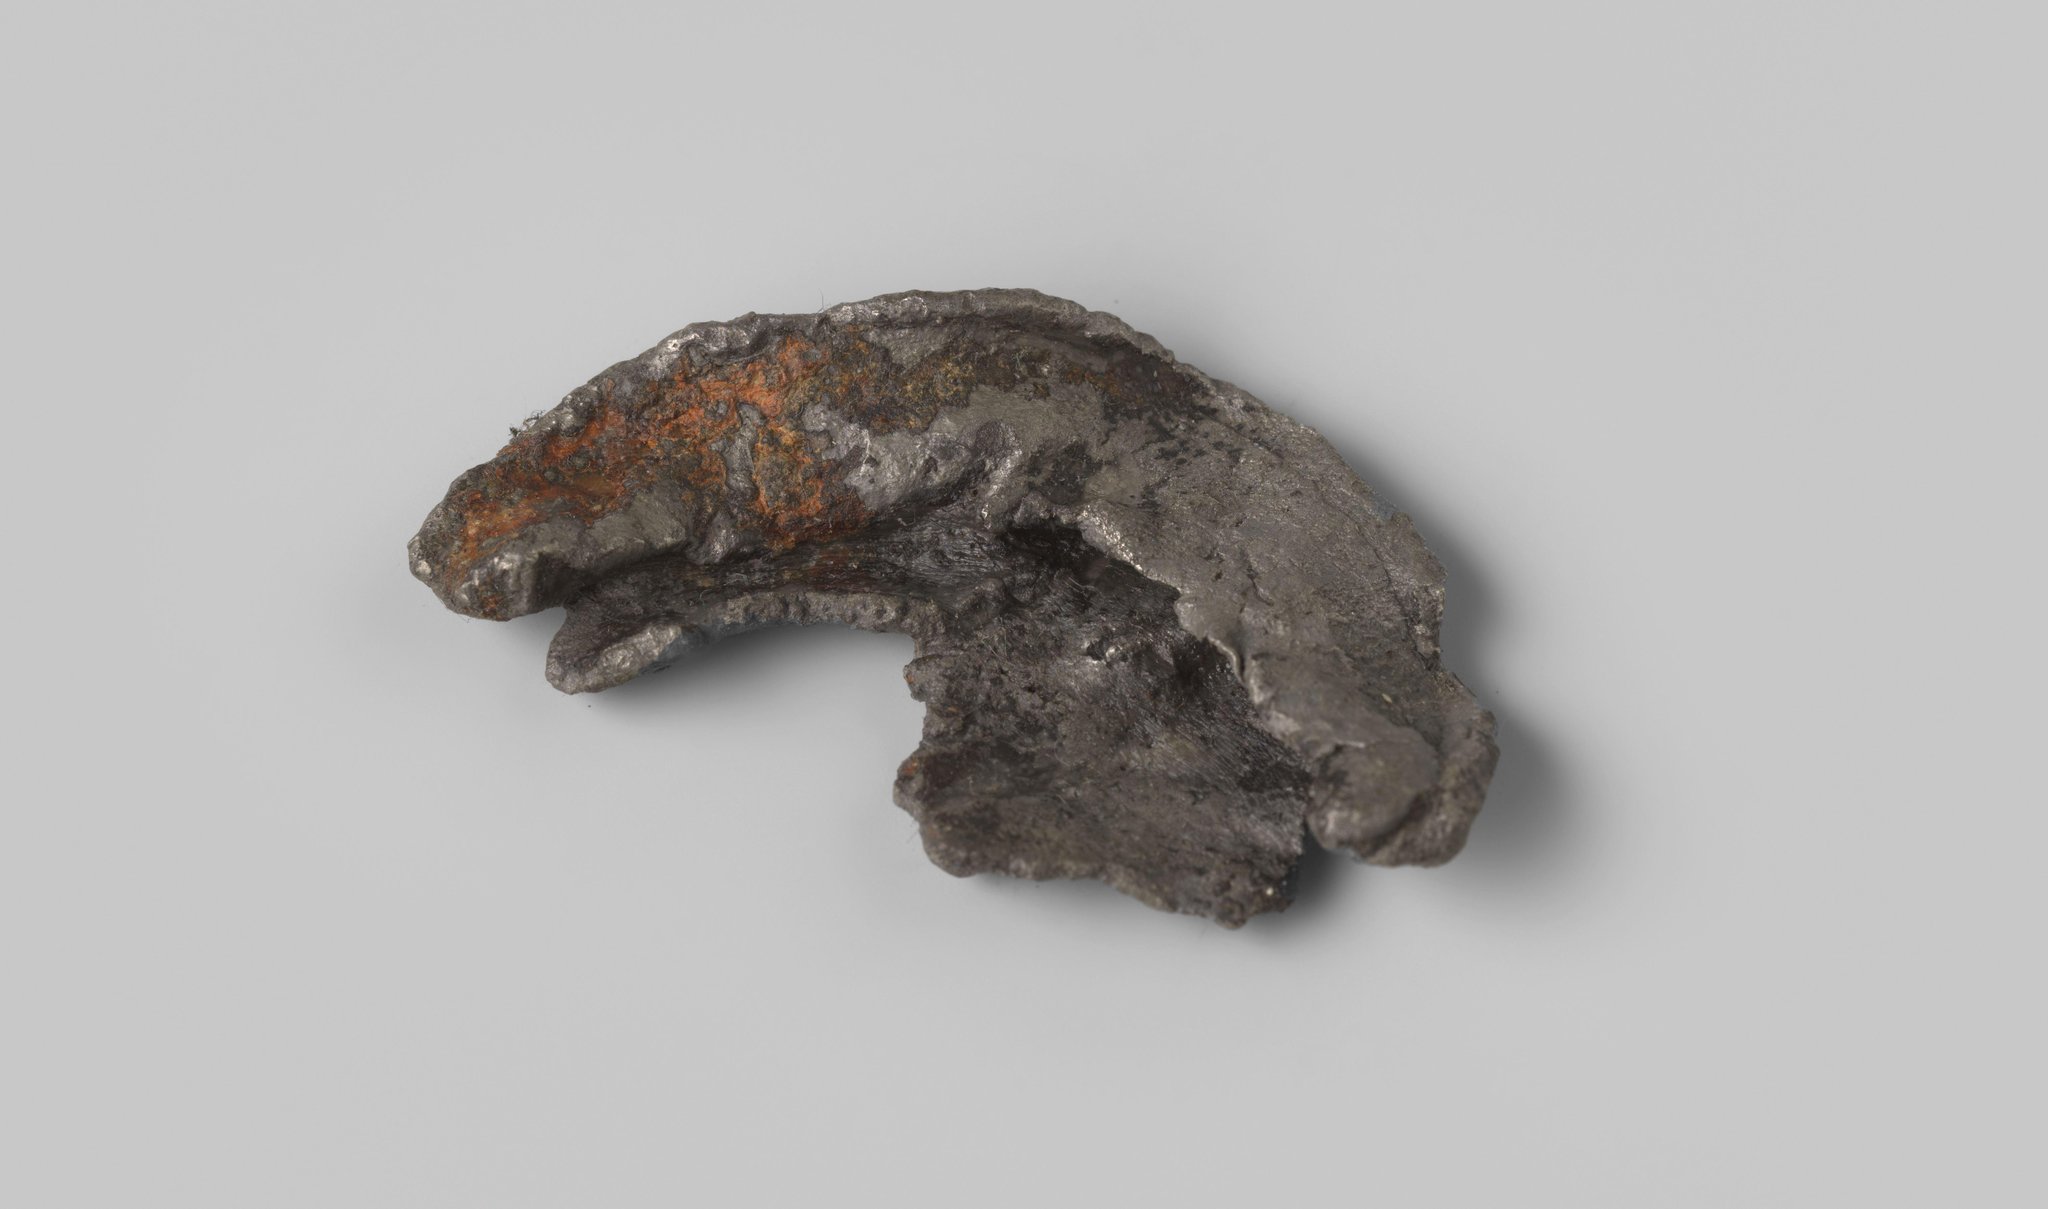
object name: verpakking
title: Fragment montuur van een verpakking uit het wrak van de Oost-Indiëvaarder Hollandia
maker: Anonymous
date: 1700-1743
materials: tin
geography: netherlands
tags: verenigde oostindische compagnie, hollandia (schip), annet